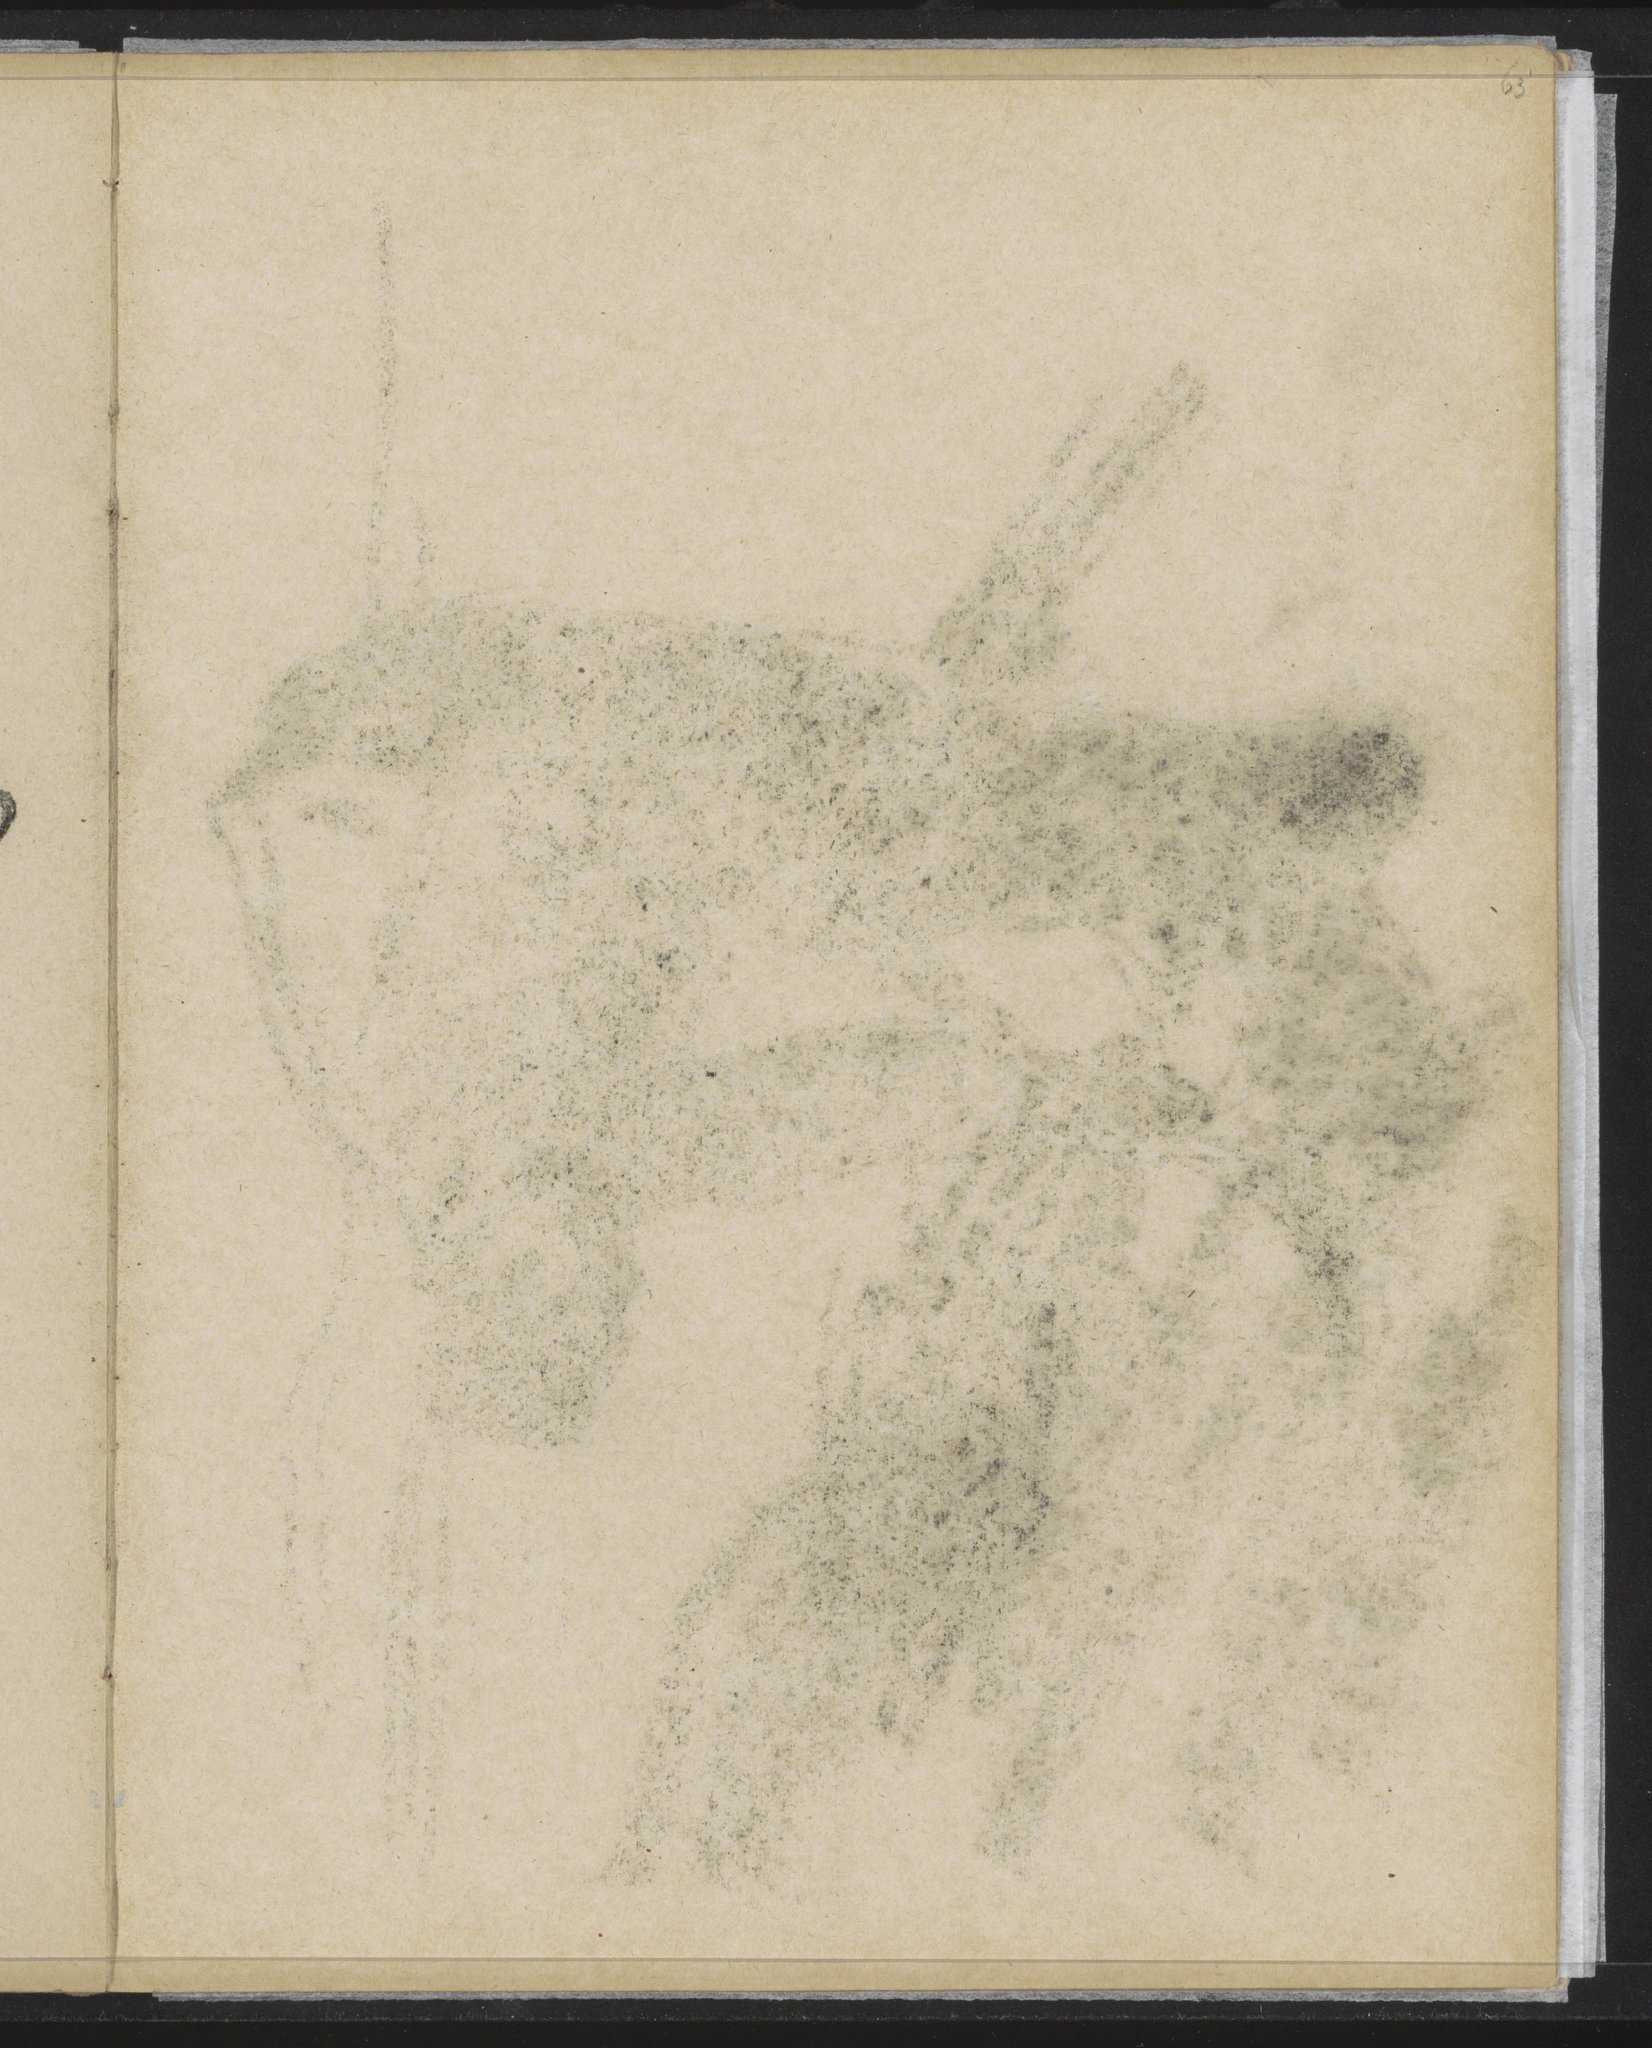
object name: sketchbook leaf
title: Abklatsch van de krijttekening op pagina 62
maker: willem witsen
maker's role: draughtsman, painter, print maker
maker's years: 1860-1923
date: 1884-1891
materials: paper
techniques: printmaking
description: Pagina 63 uit een schetsboek met 49 bladen.